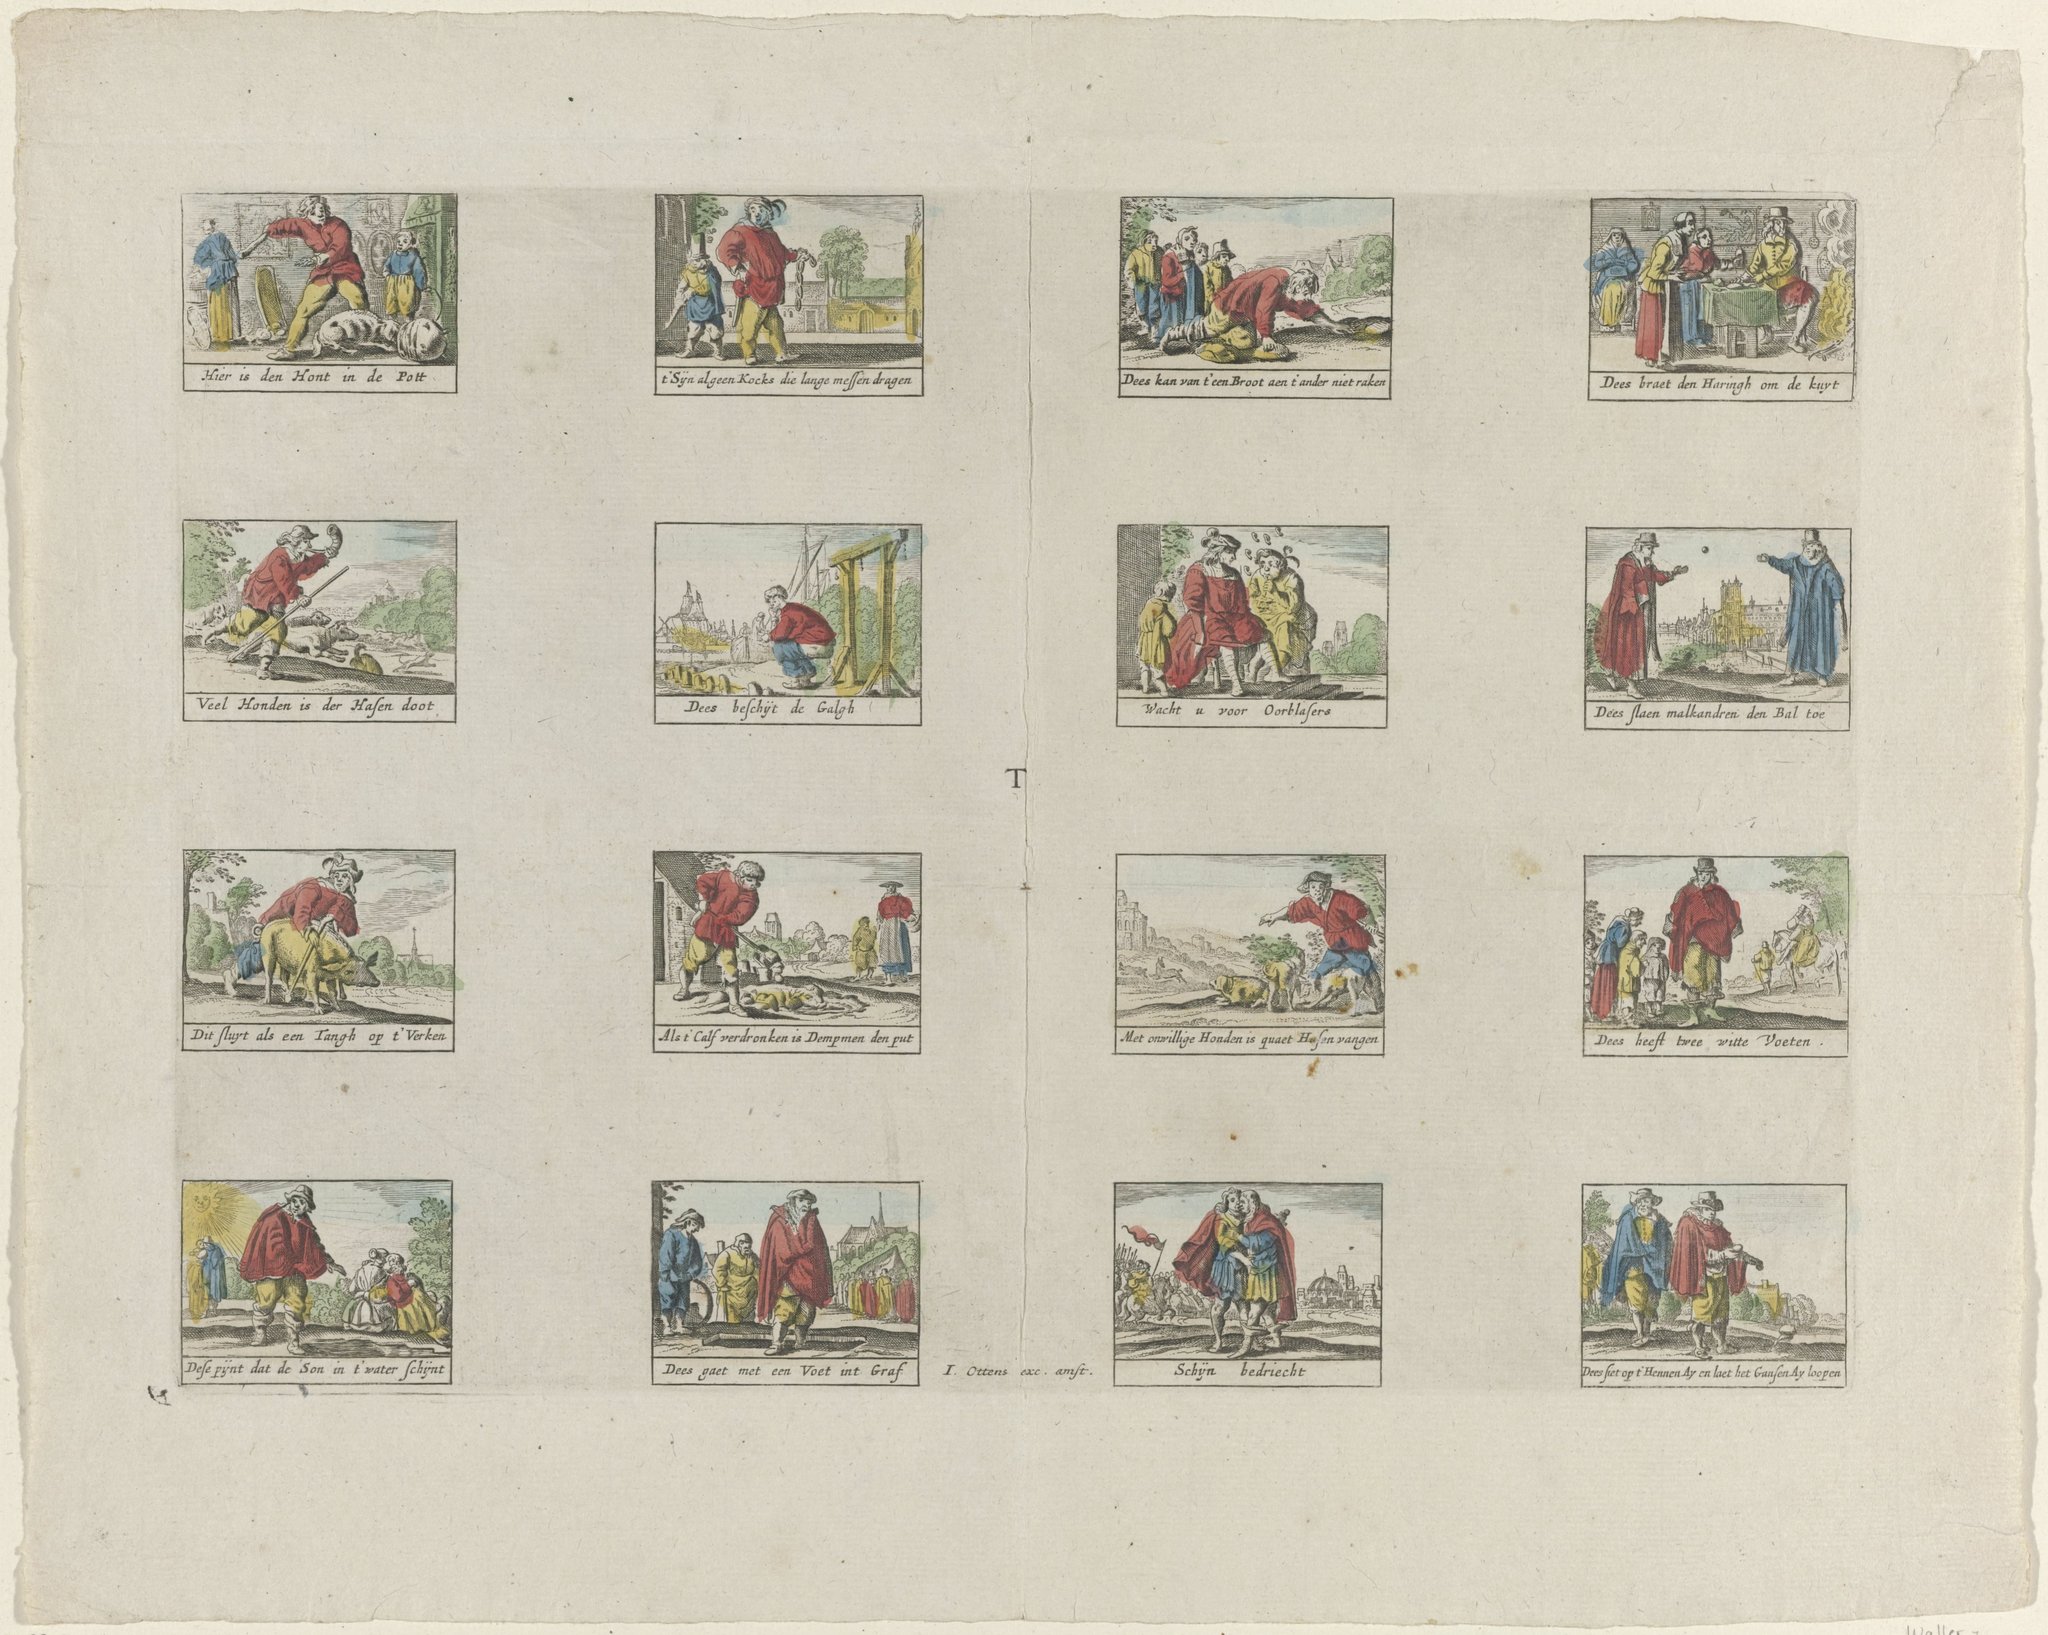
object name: popular print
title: Uitdrukkingen en gezegden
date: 1689-1720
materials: paper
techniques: colour, engraving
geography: amsterdam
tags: proverbs, sayings, etc.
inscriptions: collector's mark: Lugt 2760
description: Blad met 16 uitbeeldingen van uitdrukkingen en gezegden, waaronder "Dees beschijt de galgh", "Schijn bedriecht" en "Dees heeft twee witte voeten". Onder elke afbeelding een onderschrift. Gemerkt midden: T.